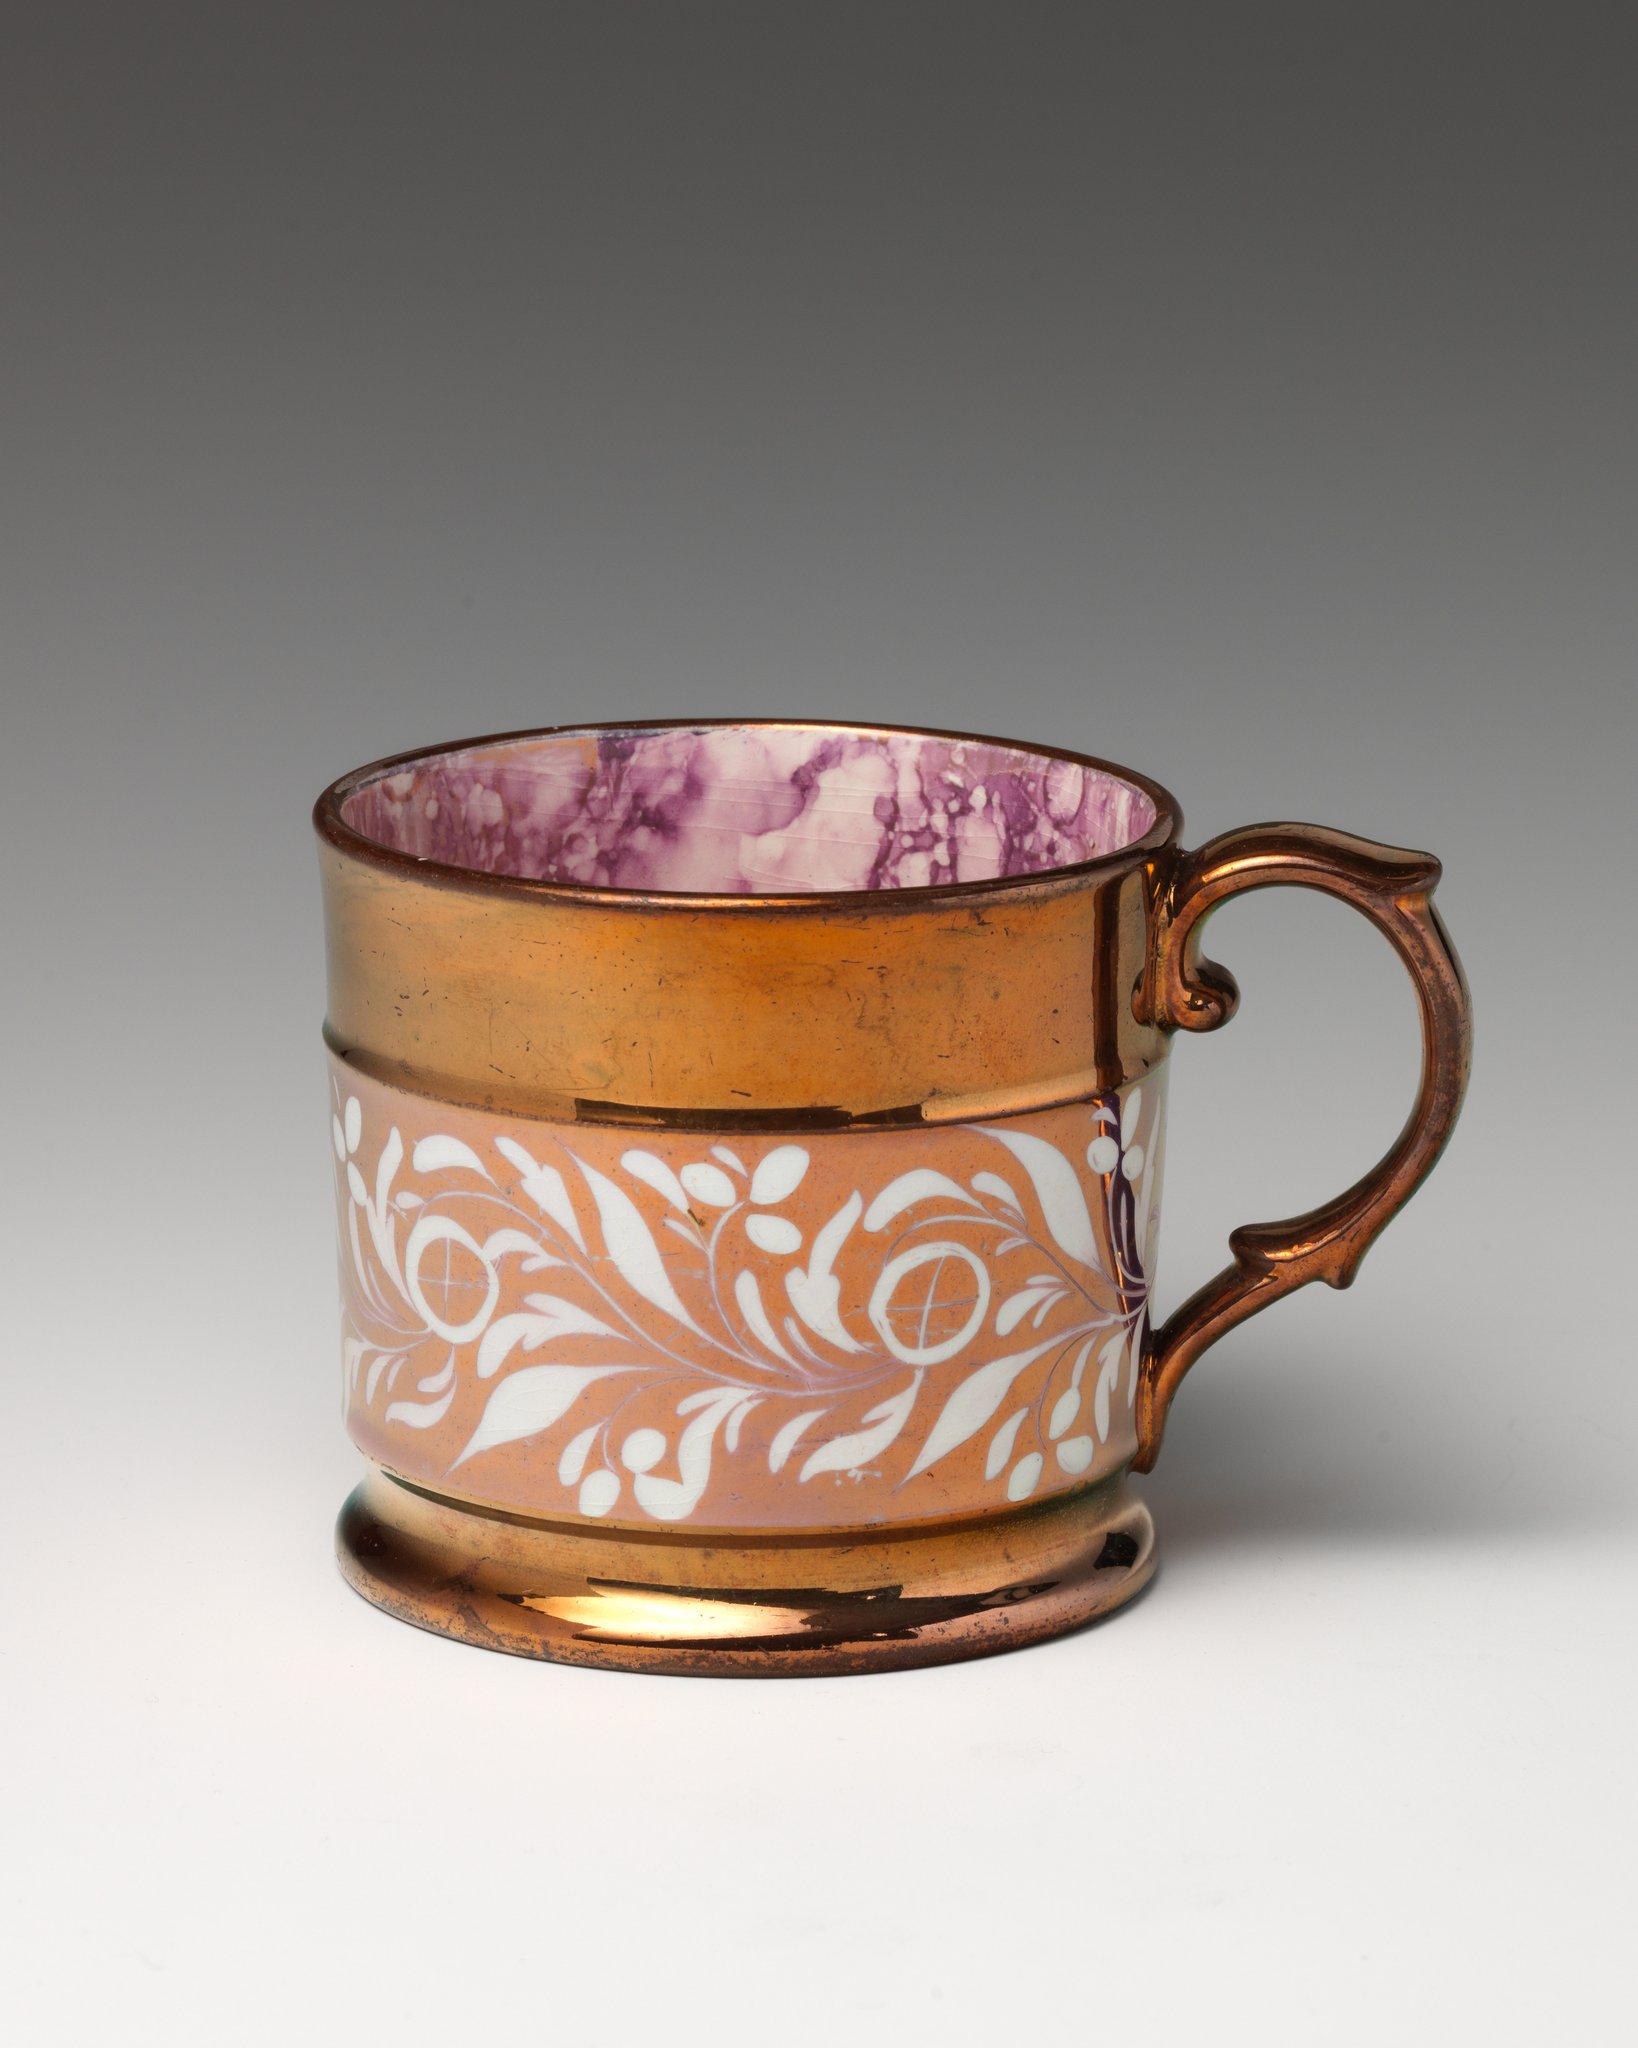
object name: mug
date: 1801-1900